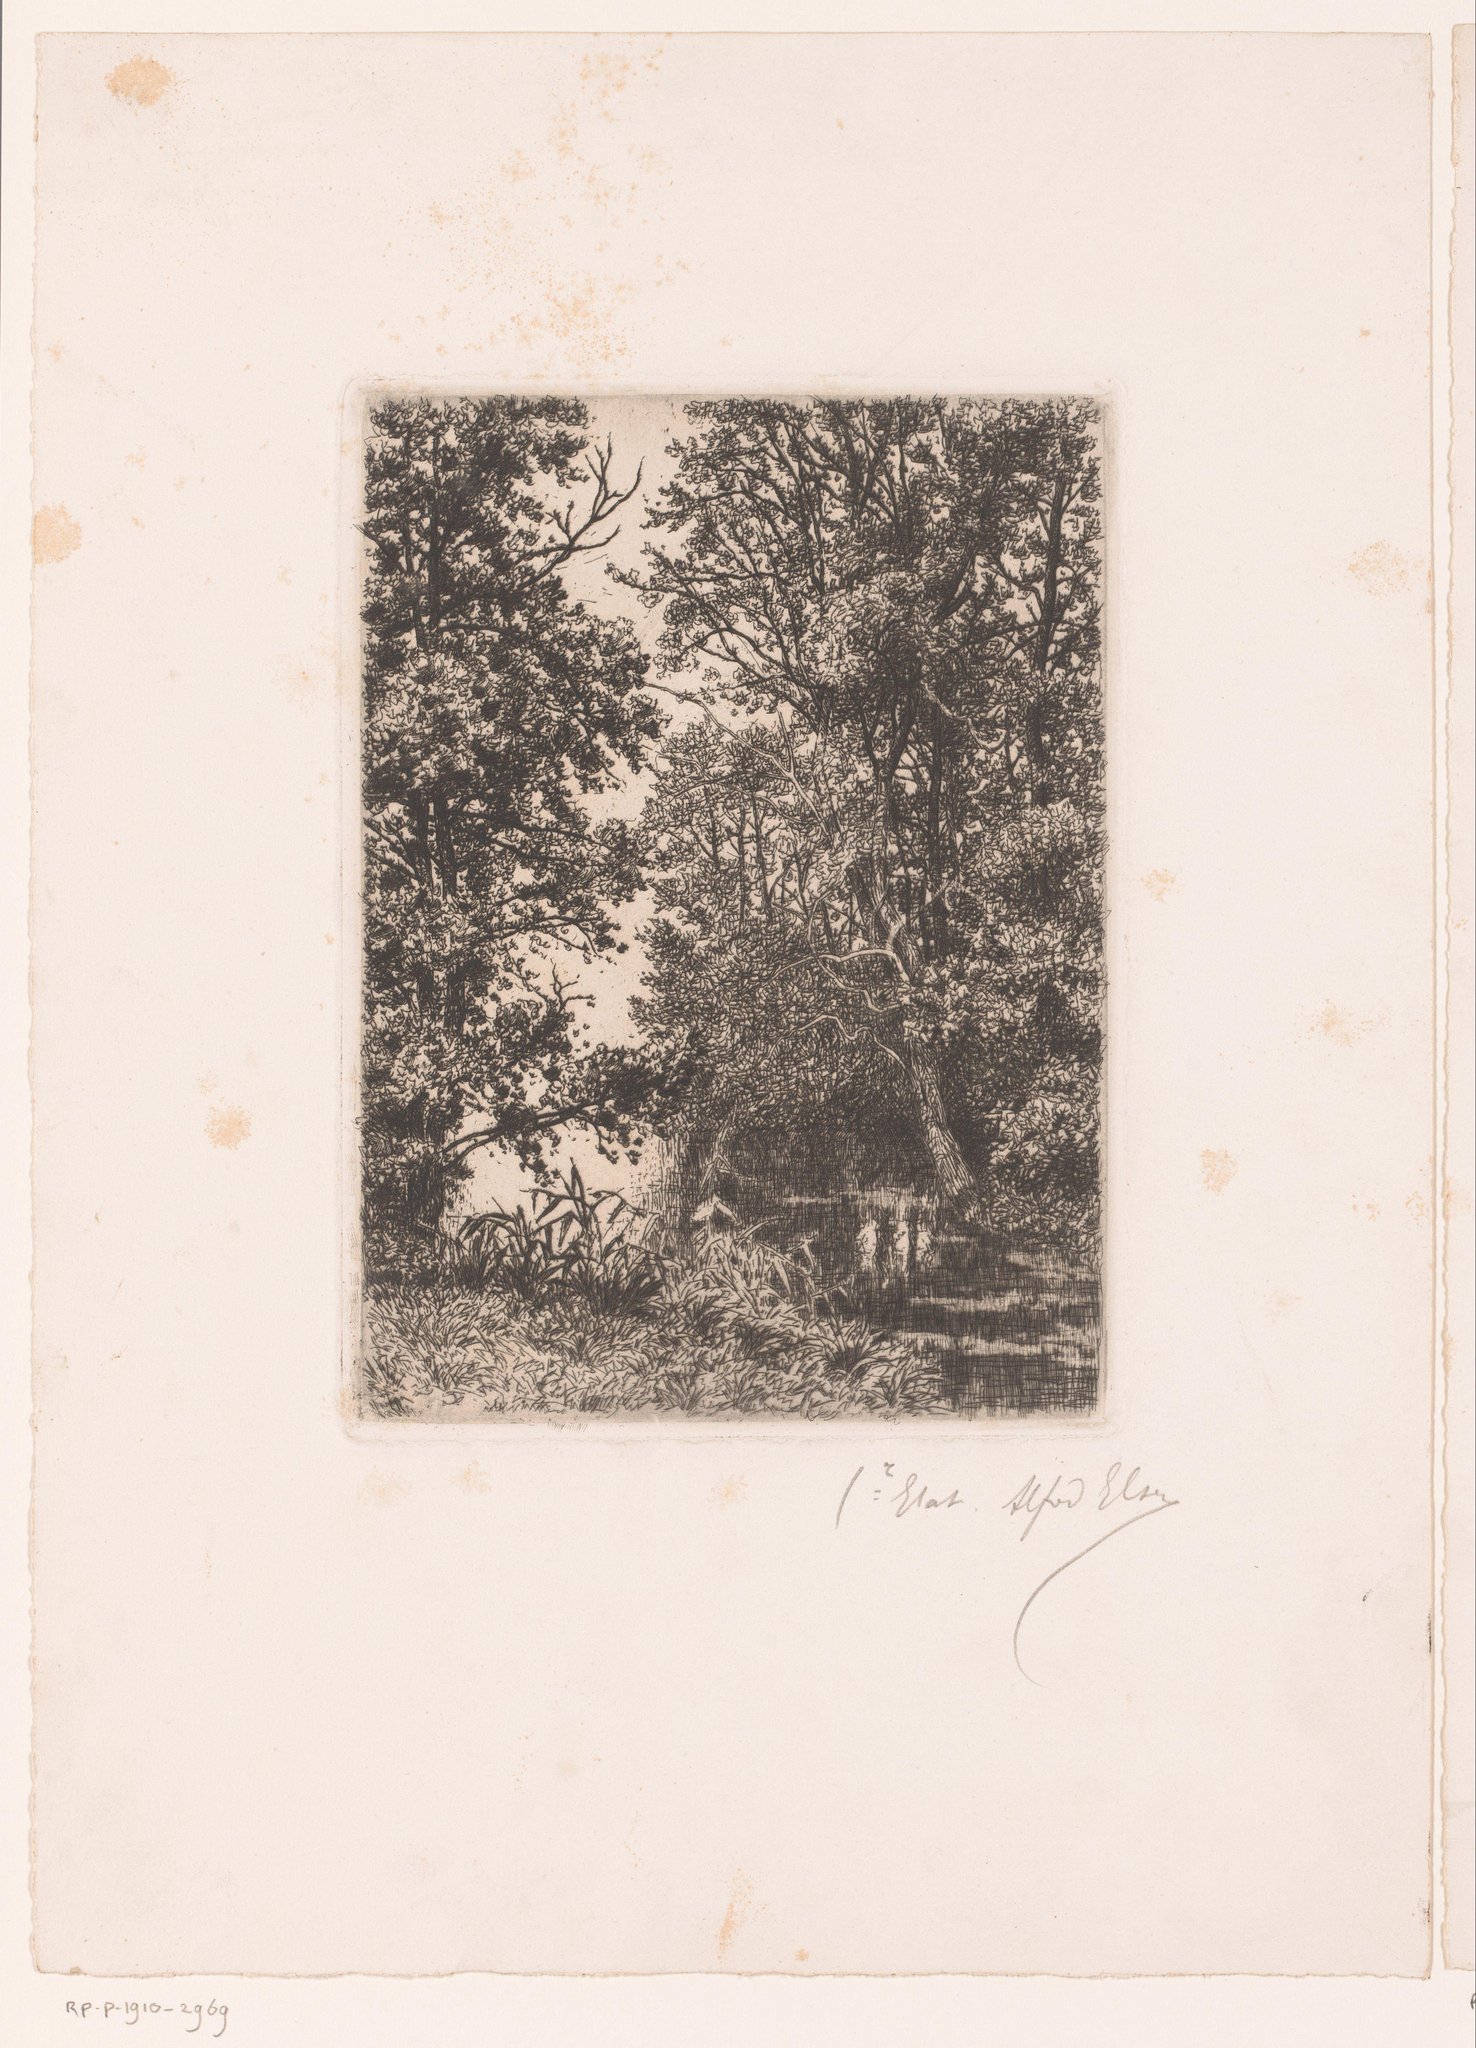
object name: print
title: Bebossing rondom een meer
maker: alfred elsen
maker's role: painter, print maker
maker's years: 1850-1914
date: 1860-1910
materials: paper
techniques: etching, intaglio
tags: lake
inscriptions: collector's mark: Lugt 2228, inscription: ‘1e Etat’